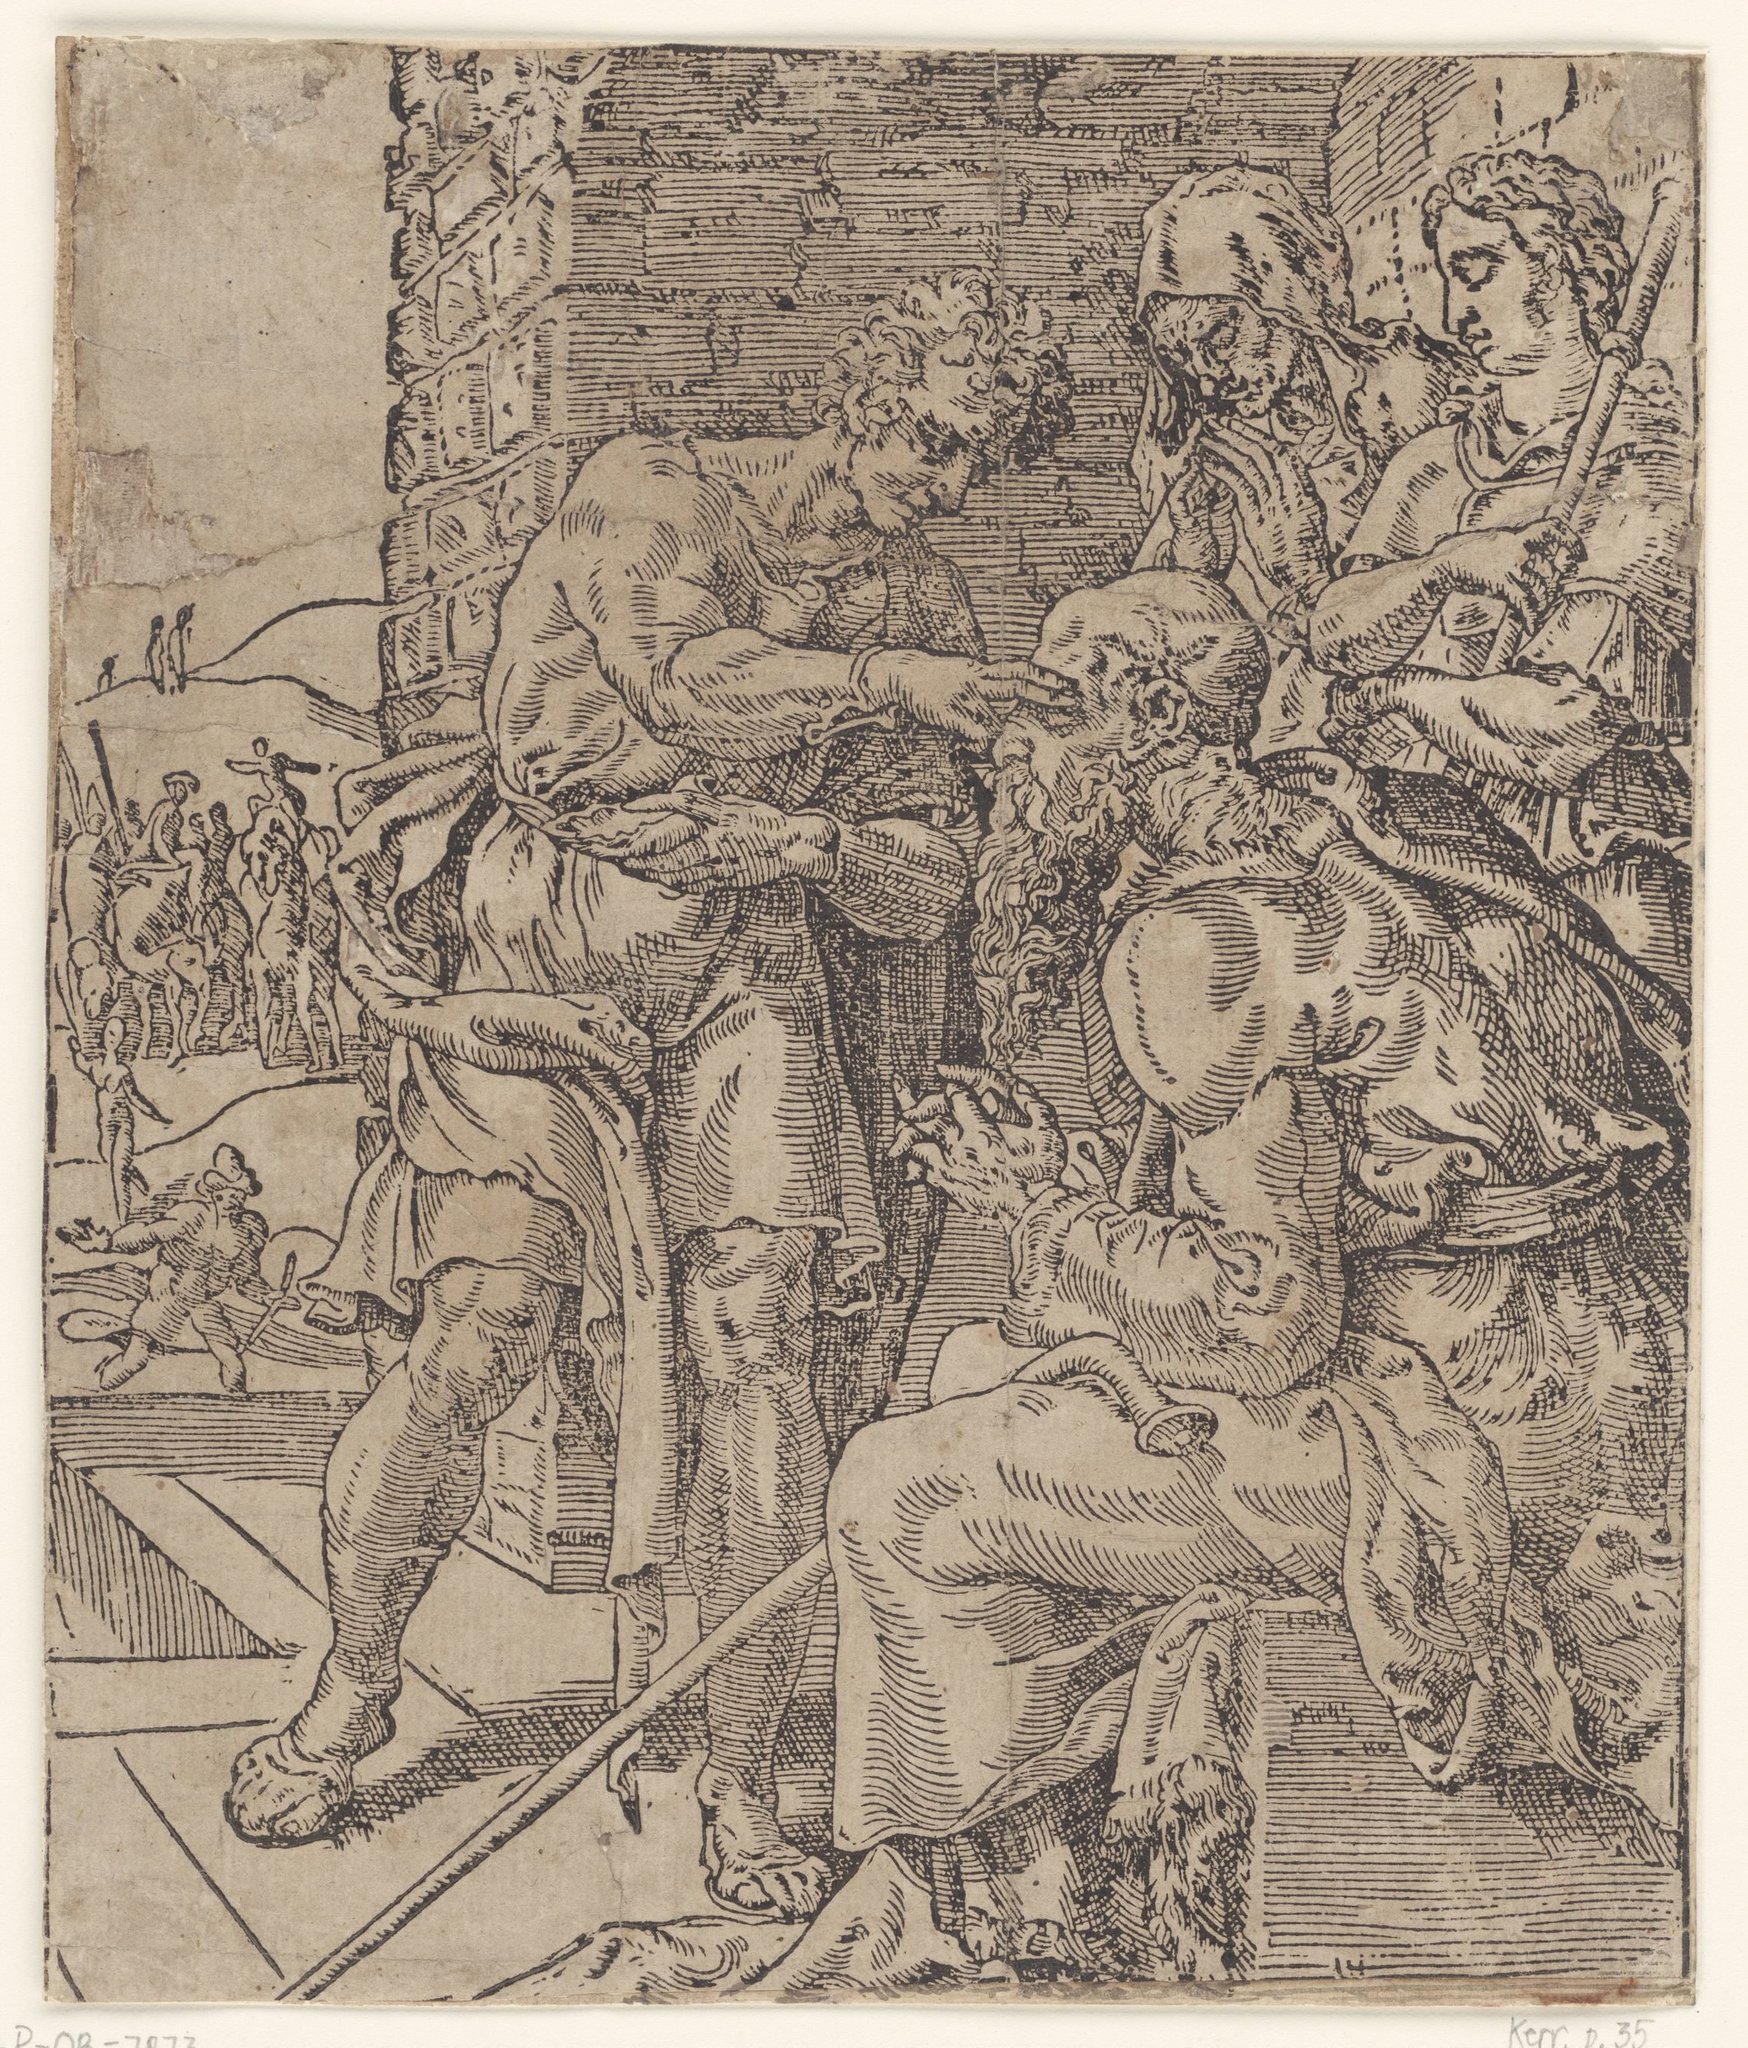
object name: print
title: Geschiedenis van Tobias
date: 1548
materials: paper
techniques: woodcut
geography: netherlands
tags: the healing of tobit: tobias puts the gall of the fish on his father's eyes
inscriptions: collector's mark: Lugt 240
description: Met de gal van een vis geneest Tobias zijn vaders blindheid. Naast hem de engel Rafaël en Anna, de moeder van Tobias.